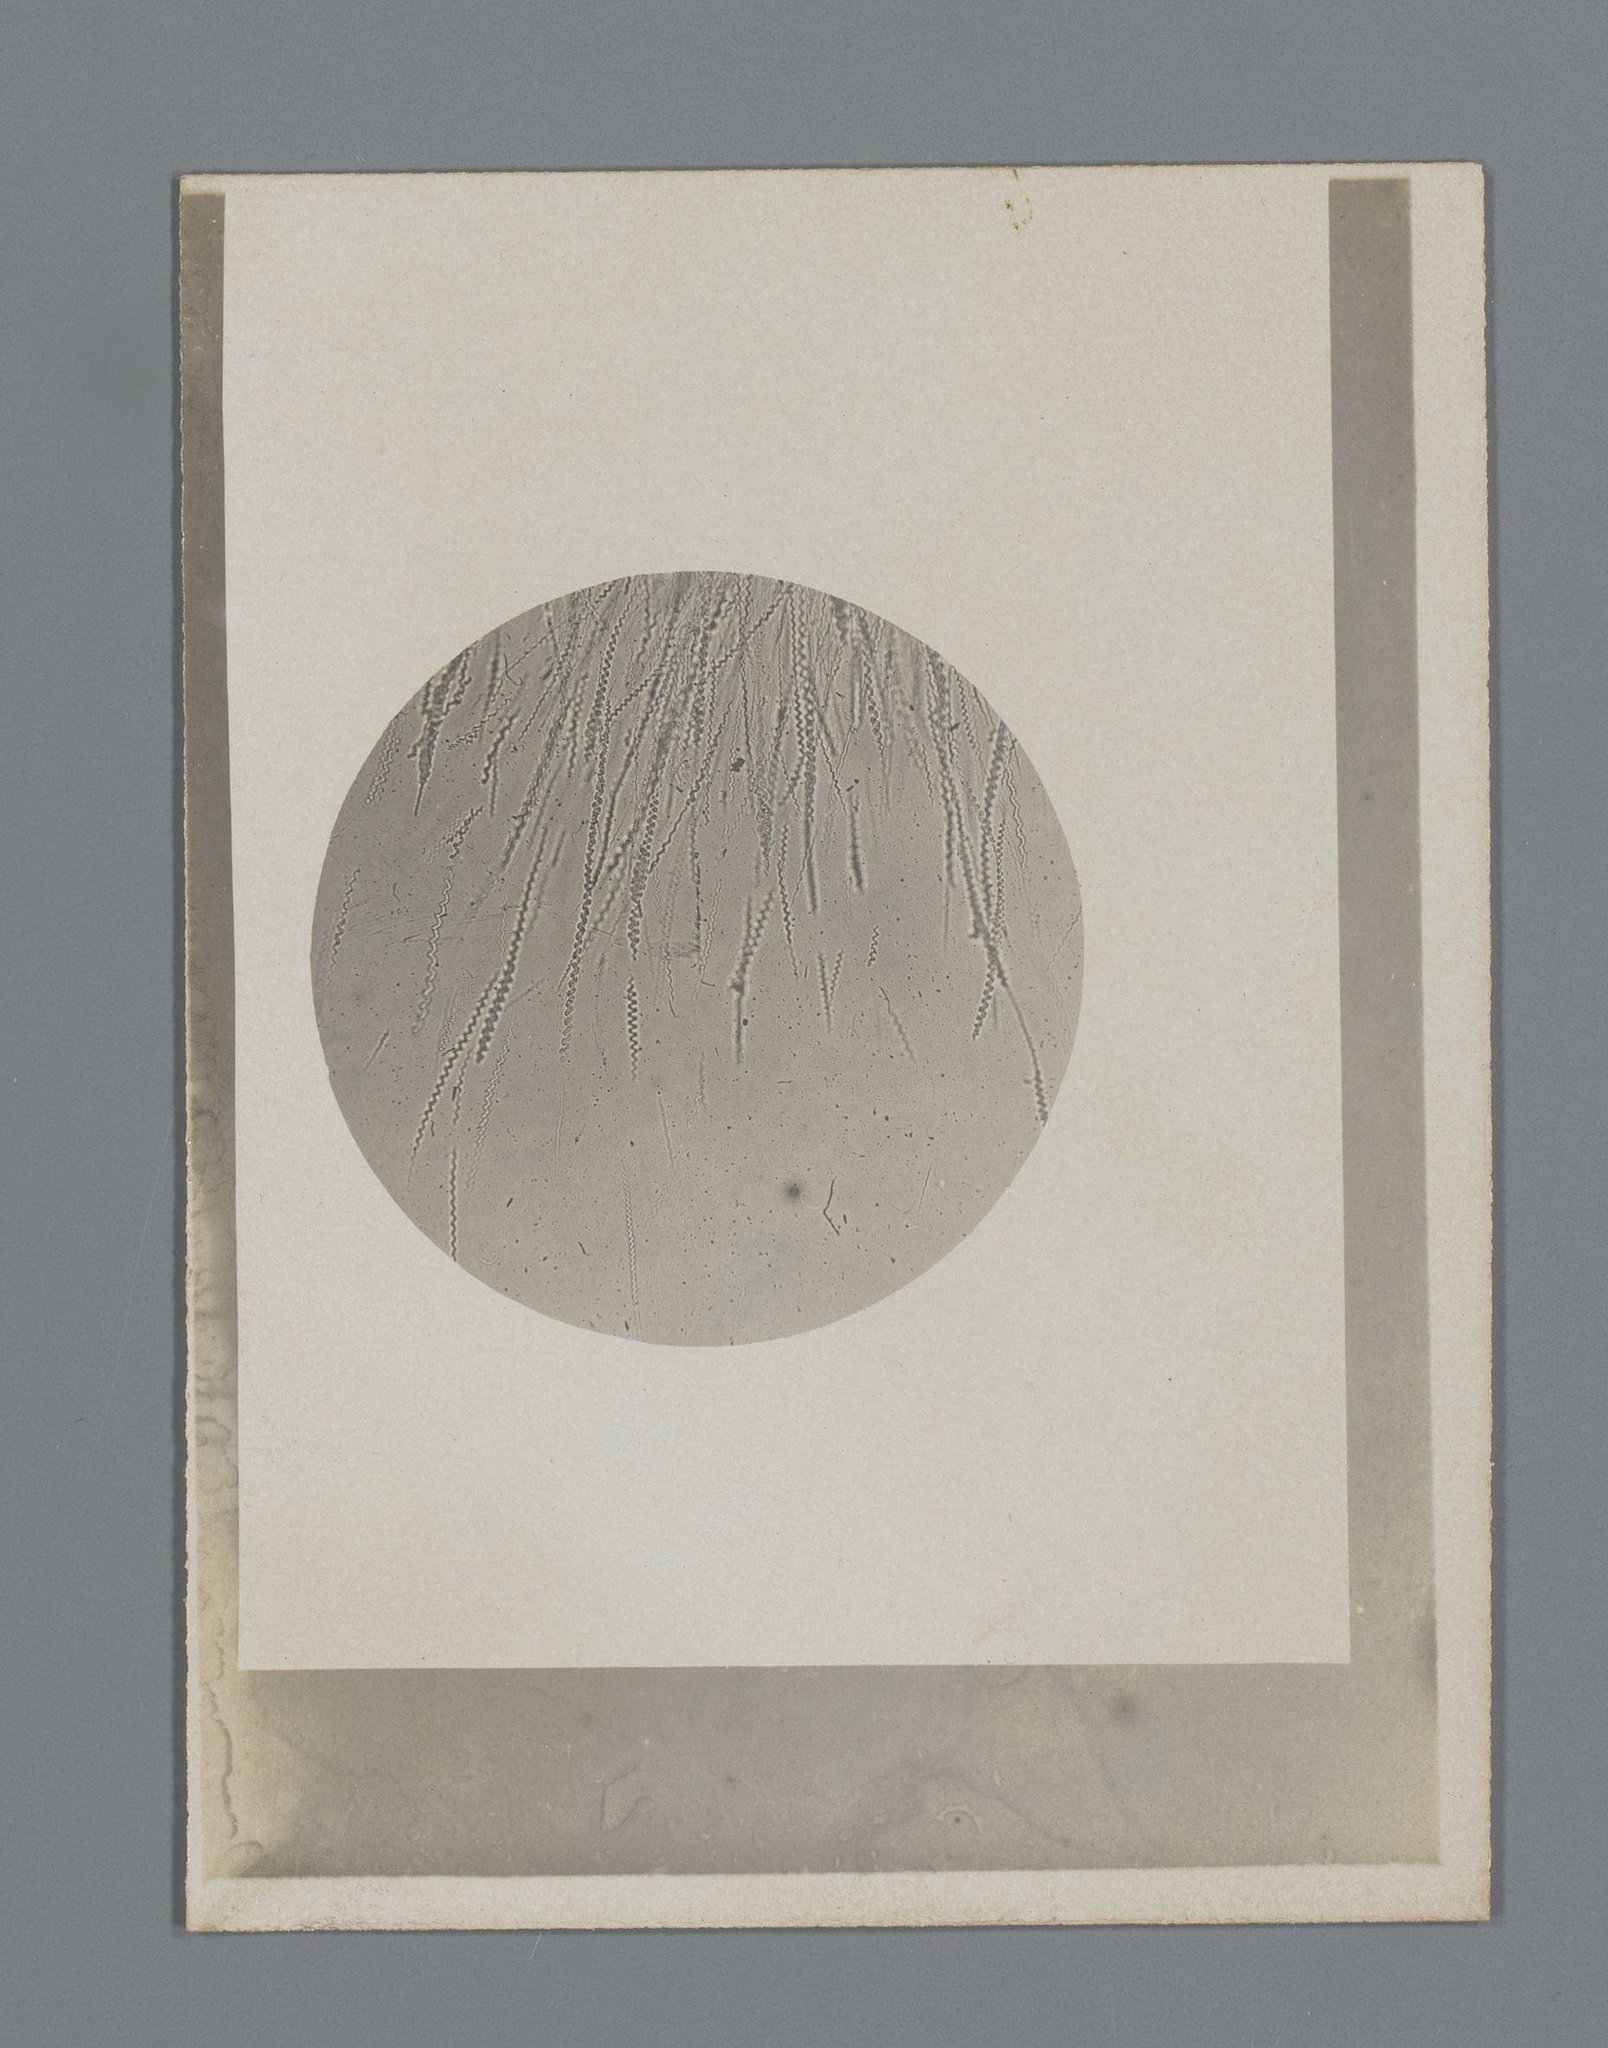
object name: photograph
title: Opname van een microscopisch preparaat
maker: Anonymous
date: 1880-1910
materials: paper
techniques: gelatin silver print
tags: unicellular animals, bacteria, bacilli